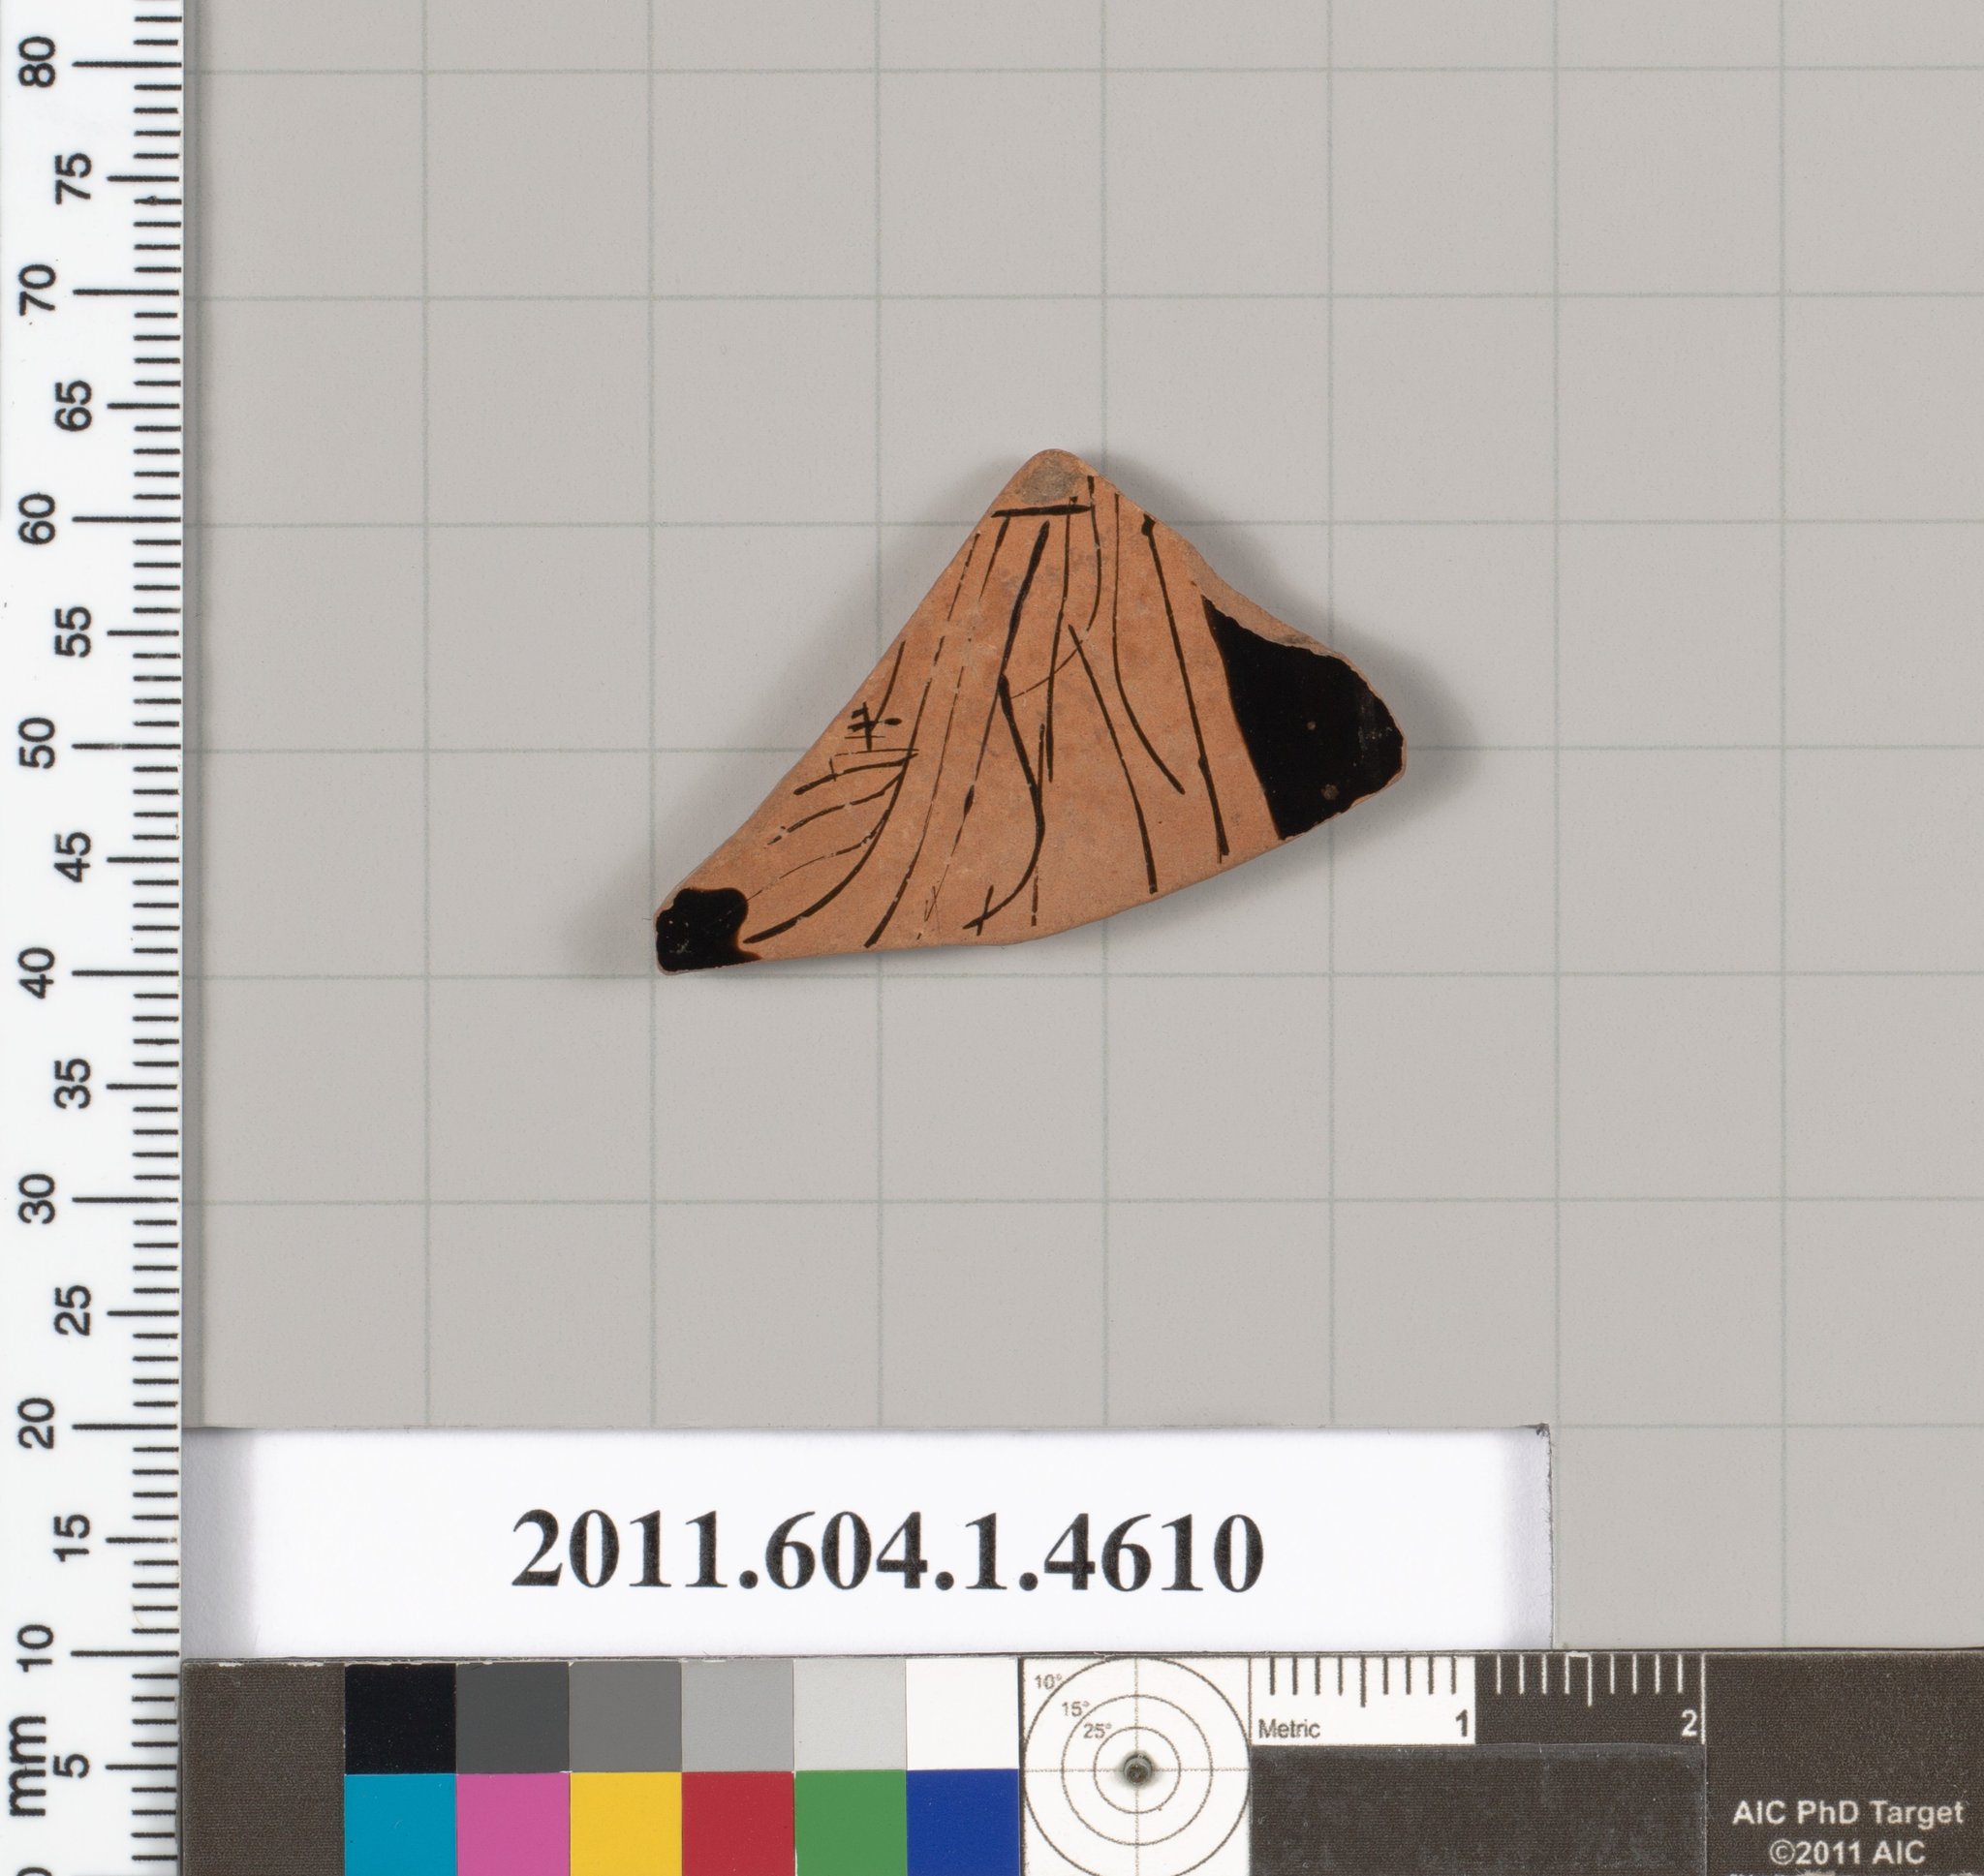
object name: kylix fragment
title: Terracotta fragment of a kylix (drinking cup)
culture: greek, attic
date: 467-435 BCE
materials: terracotta